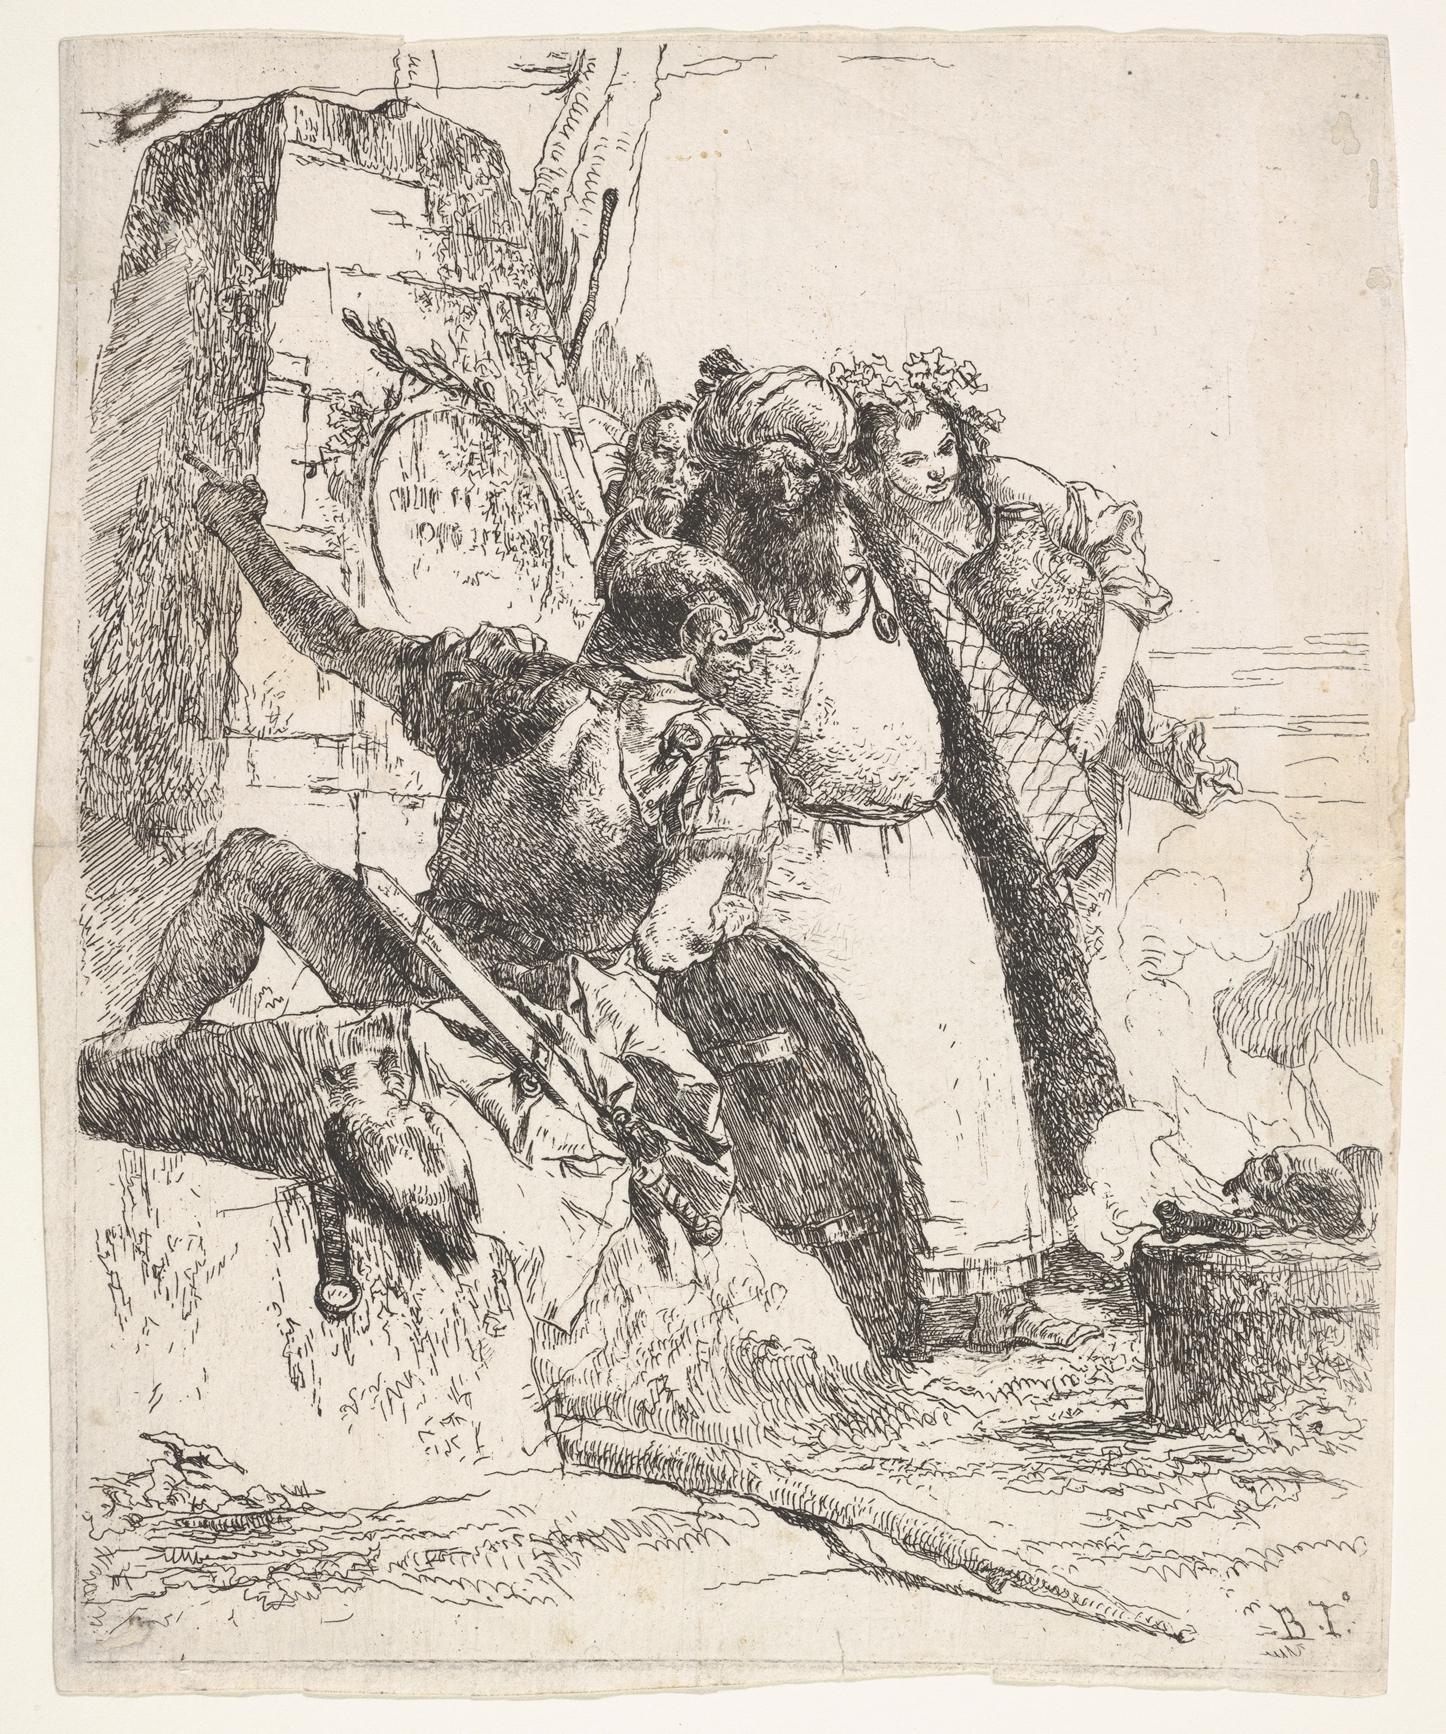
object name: print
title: A scene of necromancy: a woman bearing a vessel, a turbaned man, and a soldier look toward a pedestal upon which a skull and limb bone are burning, a bearded male figure's face is visible behind the group, from "Turns of fantasy" (Scherzi di fantasia)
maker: giovanni battista tiepolo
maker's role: artist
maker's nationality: italian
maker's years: 1696-1770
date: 1743-1757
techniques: etching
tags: soldiers,skulls,men,women